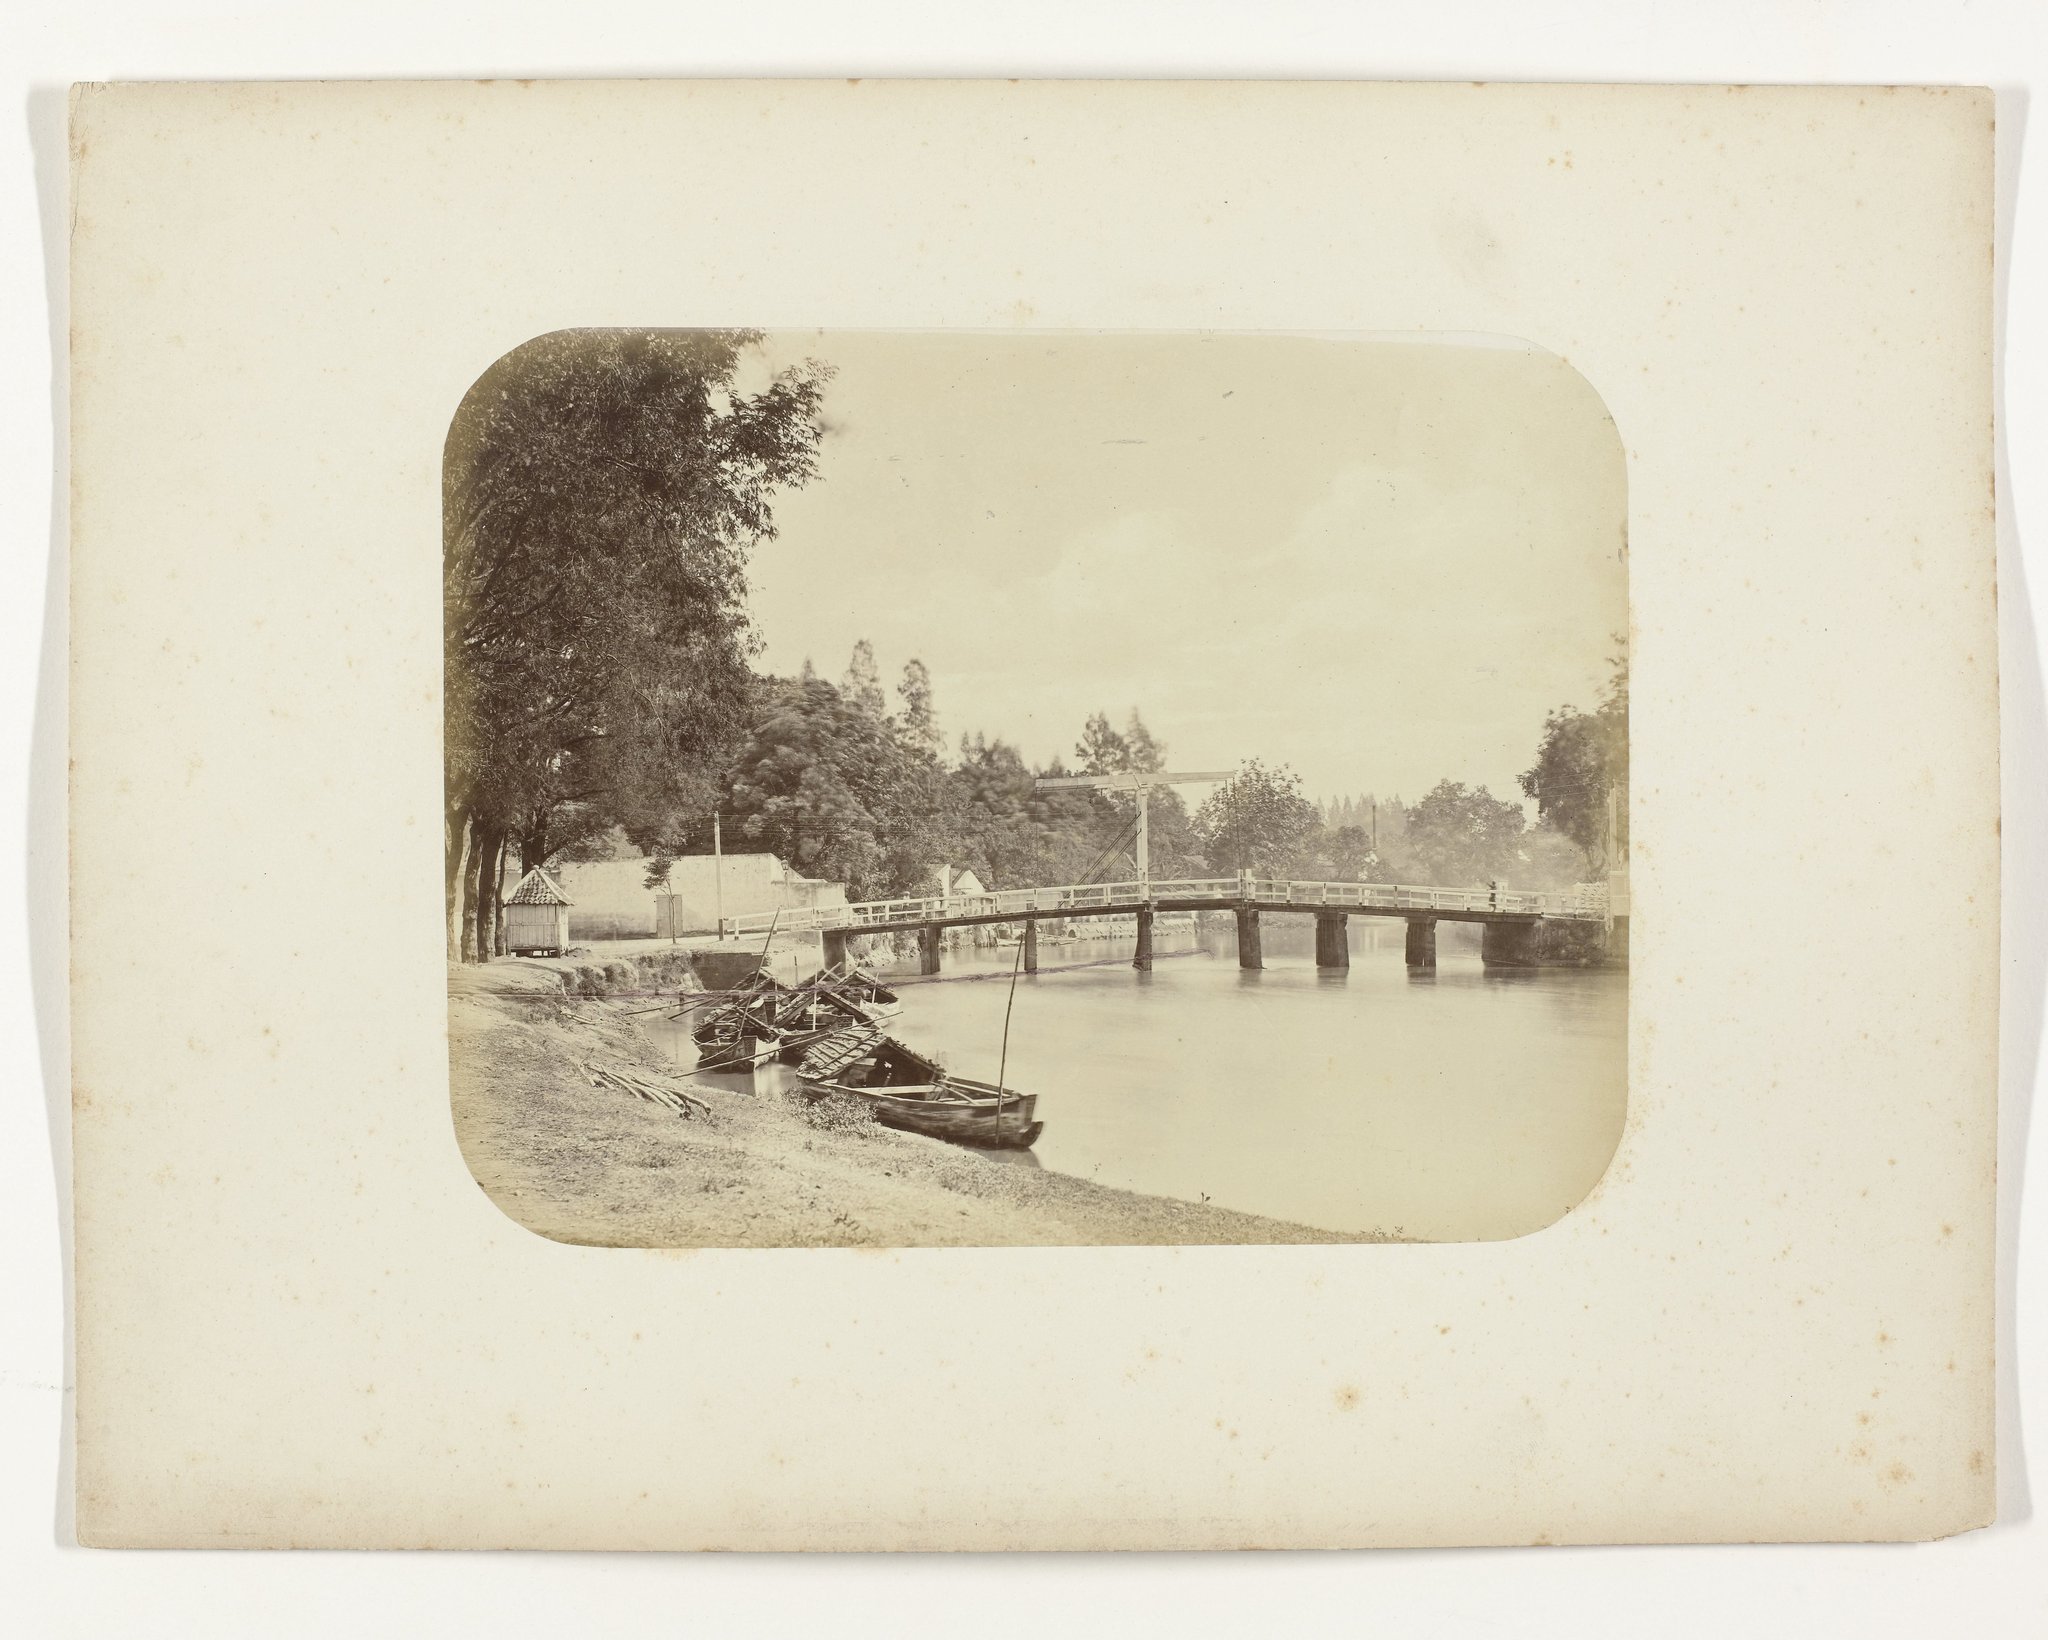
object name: photograph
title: De Kali Mas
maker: herman salzwedel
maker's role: fotograaf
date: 1876-1884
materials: photographic support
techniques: albumen print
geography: surabaya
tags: utrecht, the hague, colonial system, river, surabaya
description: De Kali Mas in Surabaya met centraal een ophaalbrug. Links liggen enkele prauwen in het water. Onderdeel van het fotoalbum door de Soerabayasche Vereeniging van Suikerfabrikanten aangeboden aan Frederik Beyerinck, resident van Soerabaja.